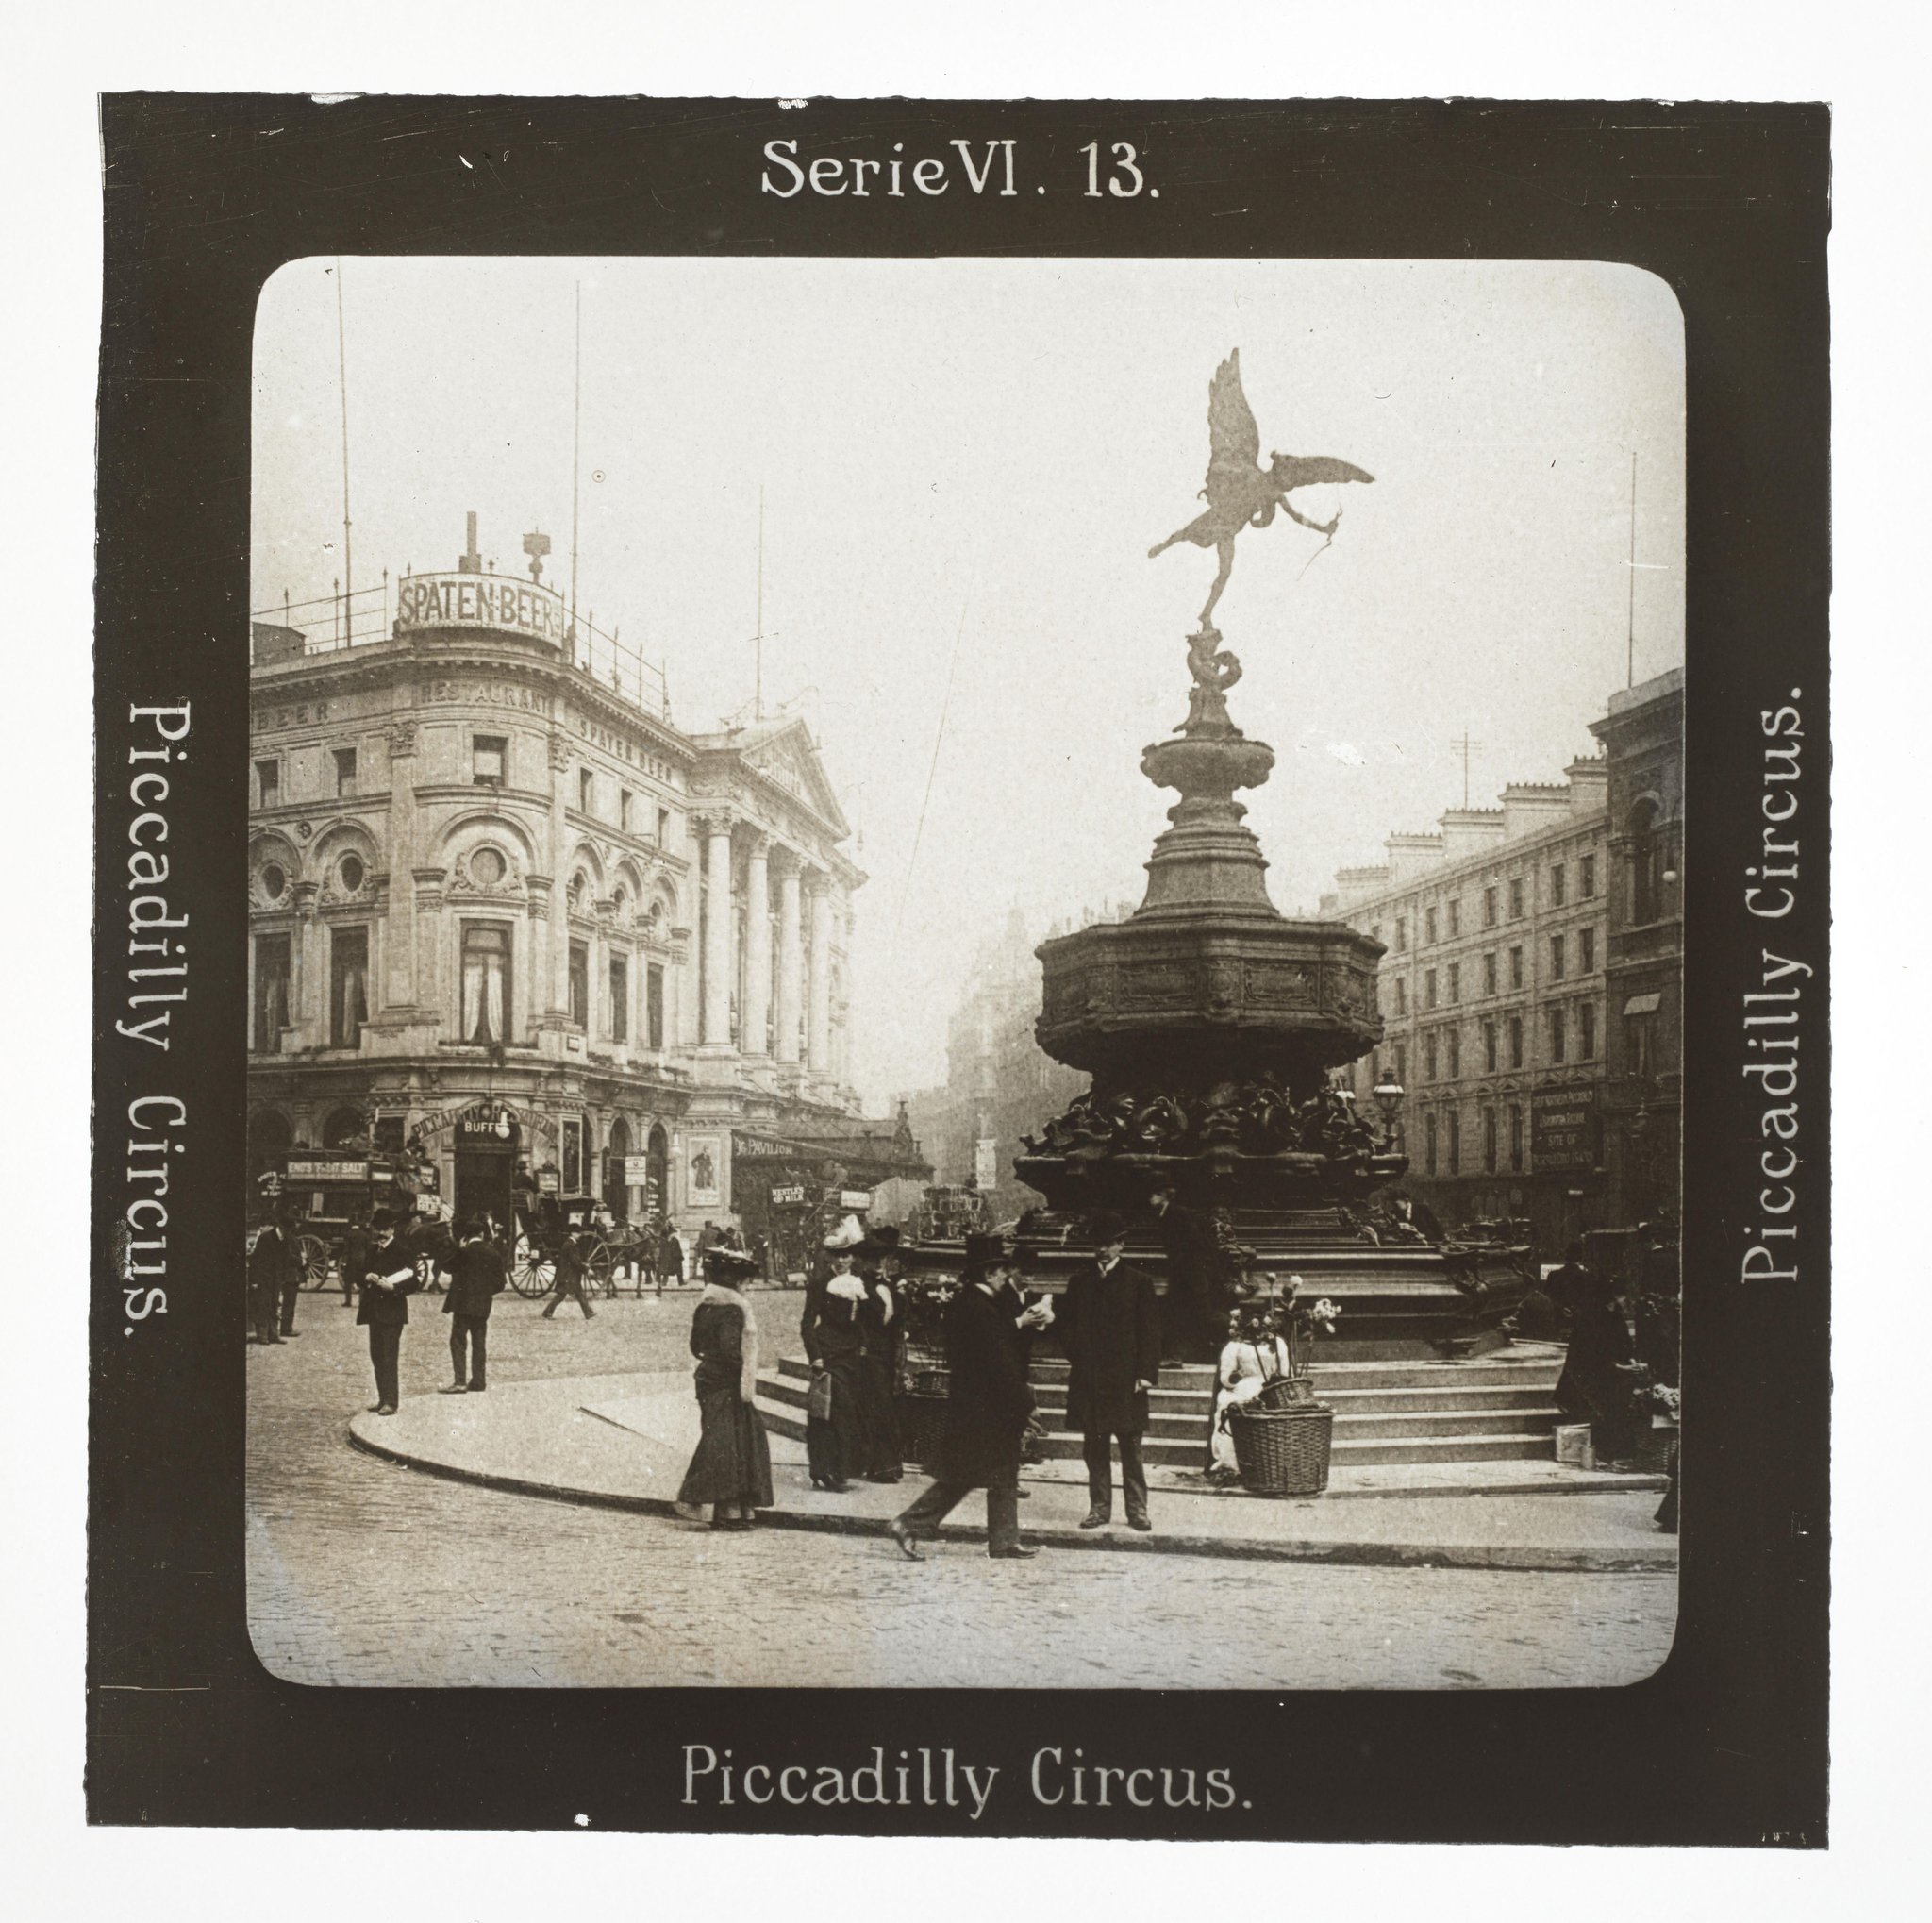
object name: lantern slide photographic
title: Piccadilly Circus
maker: Anonymous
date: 1900-1906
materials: glass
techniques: gelatin silver transparency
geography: germany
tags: square, place, circus, etc., walking, ornamental fountain